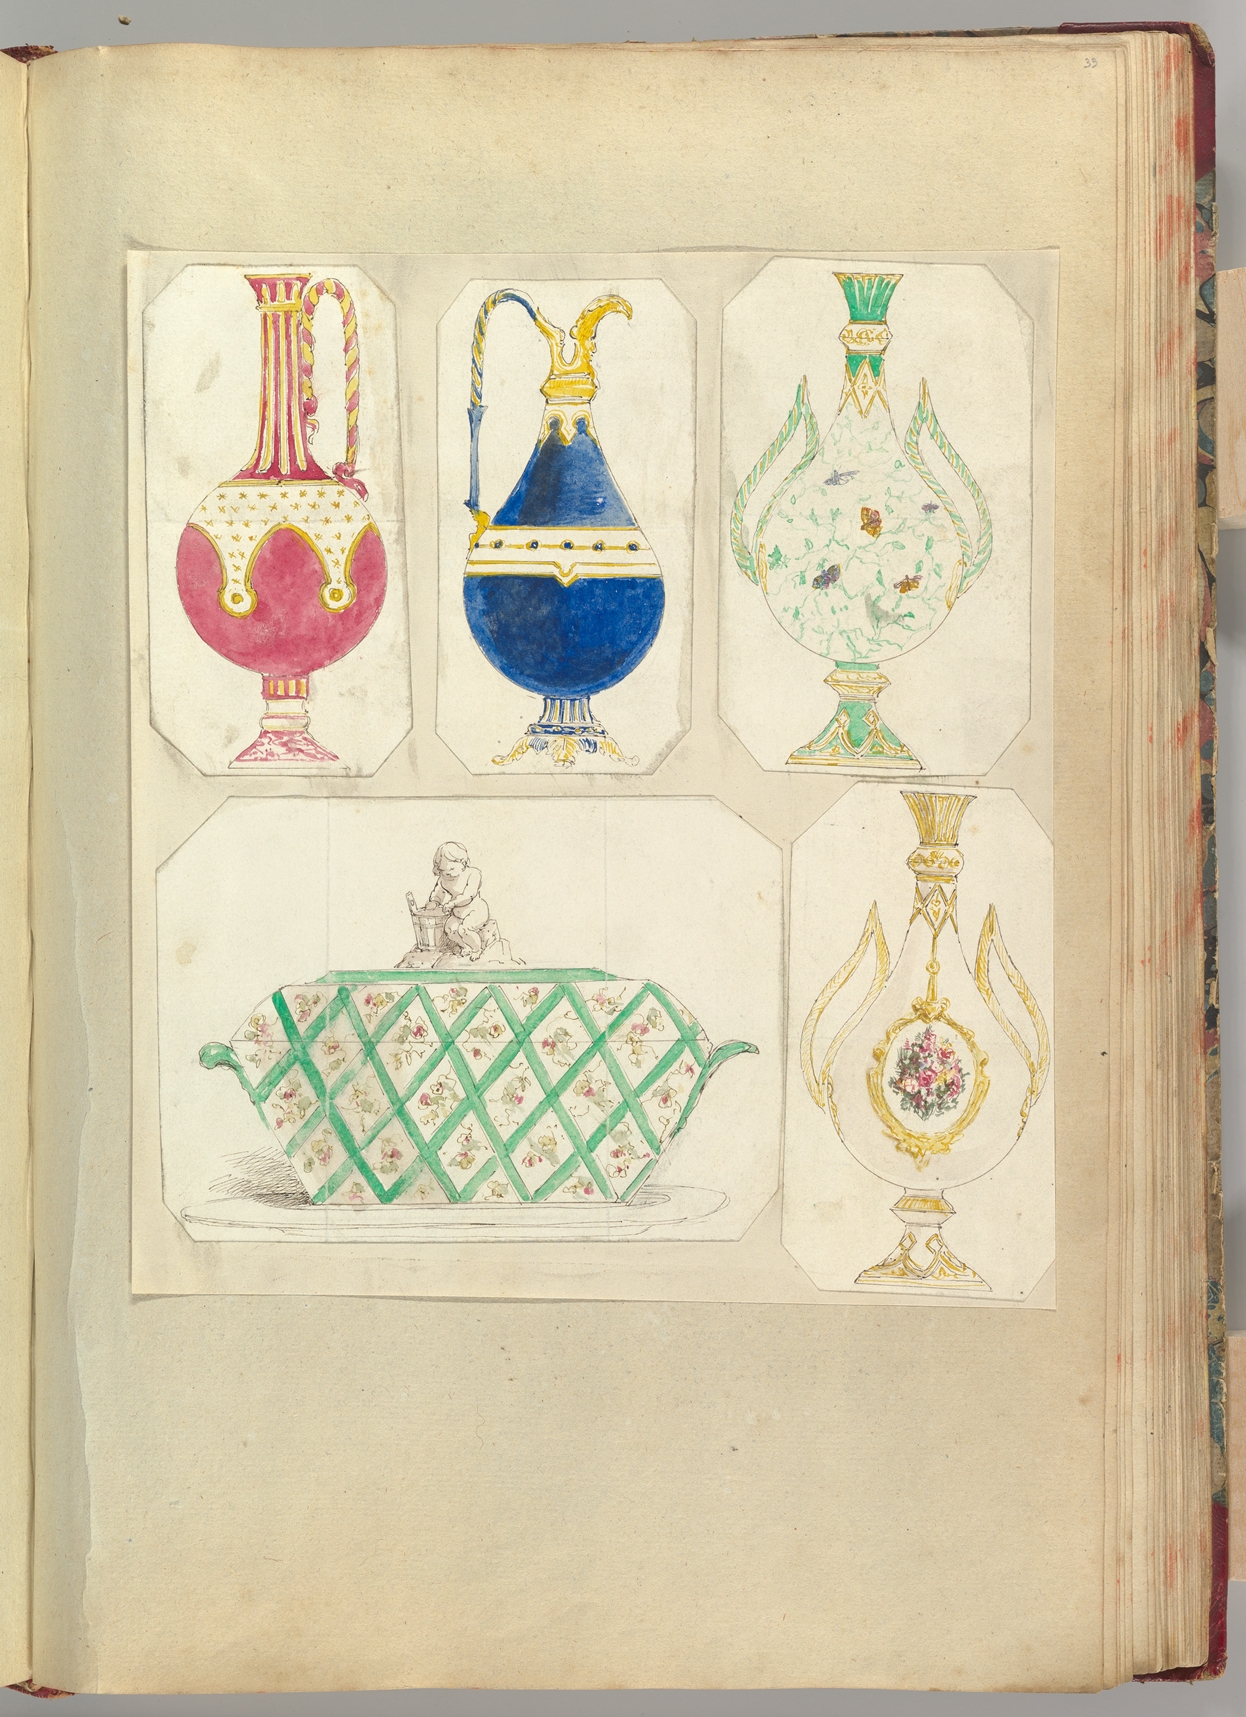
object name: drawing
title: Designs for Two Ewers, Two Bottle-shaped Vases and a Covered Tureen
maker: alfred henry forrester [alfred crowquill]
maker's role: artist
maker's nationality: british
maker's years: 1804-1872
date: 1845-1855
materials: ink, watercolor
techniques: pen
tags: ewers,vases